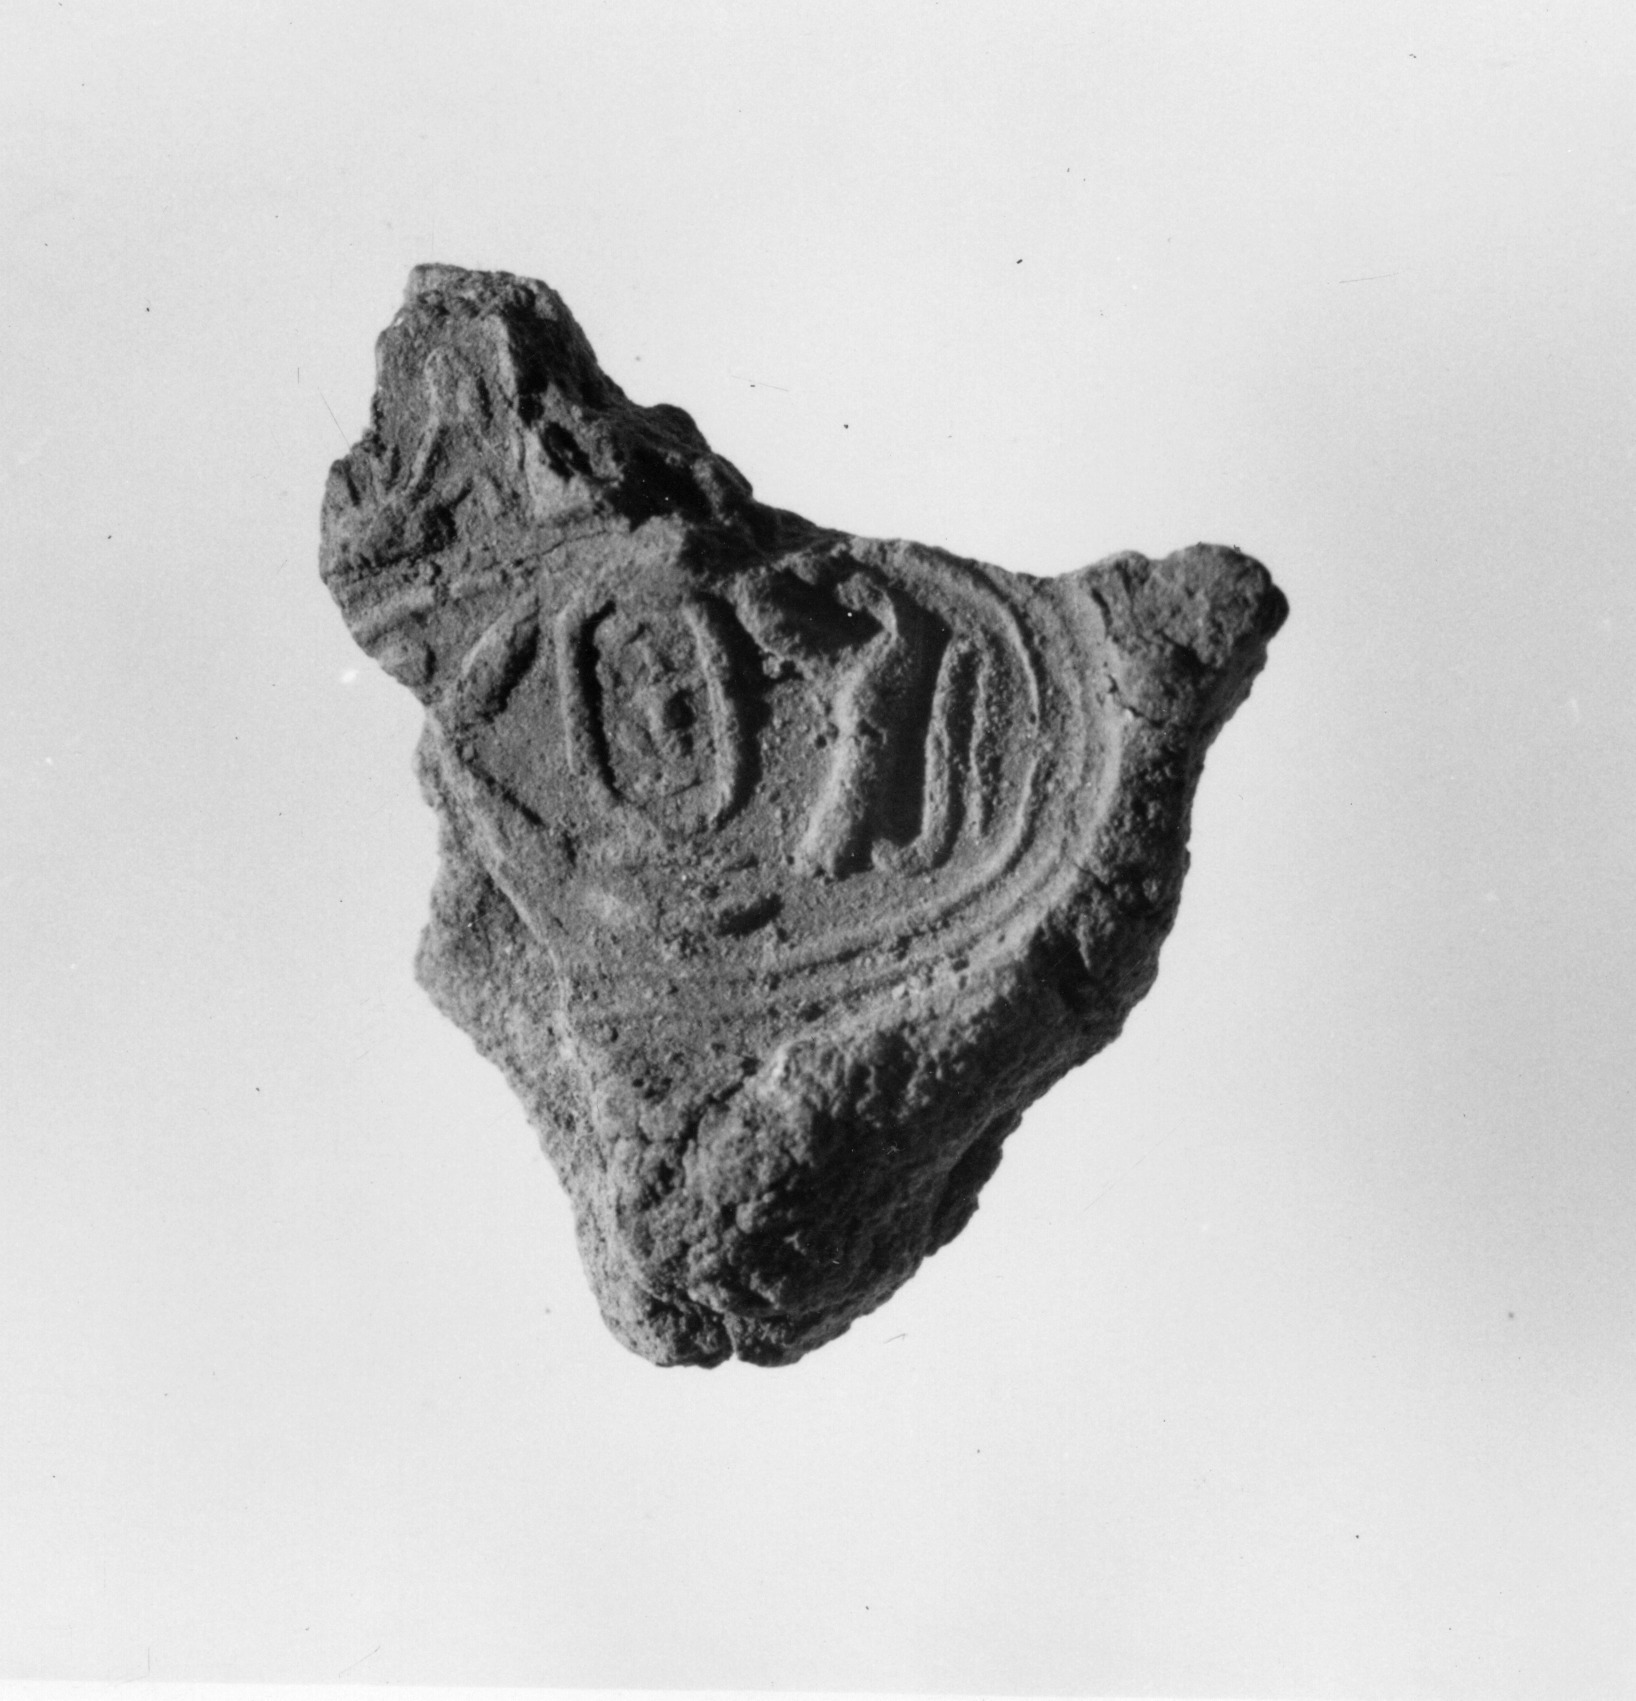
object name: sealing, amenhotep iii, nebmaatre, cobra,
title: Document Sealing With Multiple Seal Impressions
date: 1390-1352 BCE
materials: mud